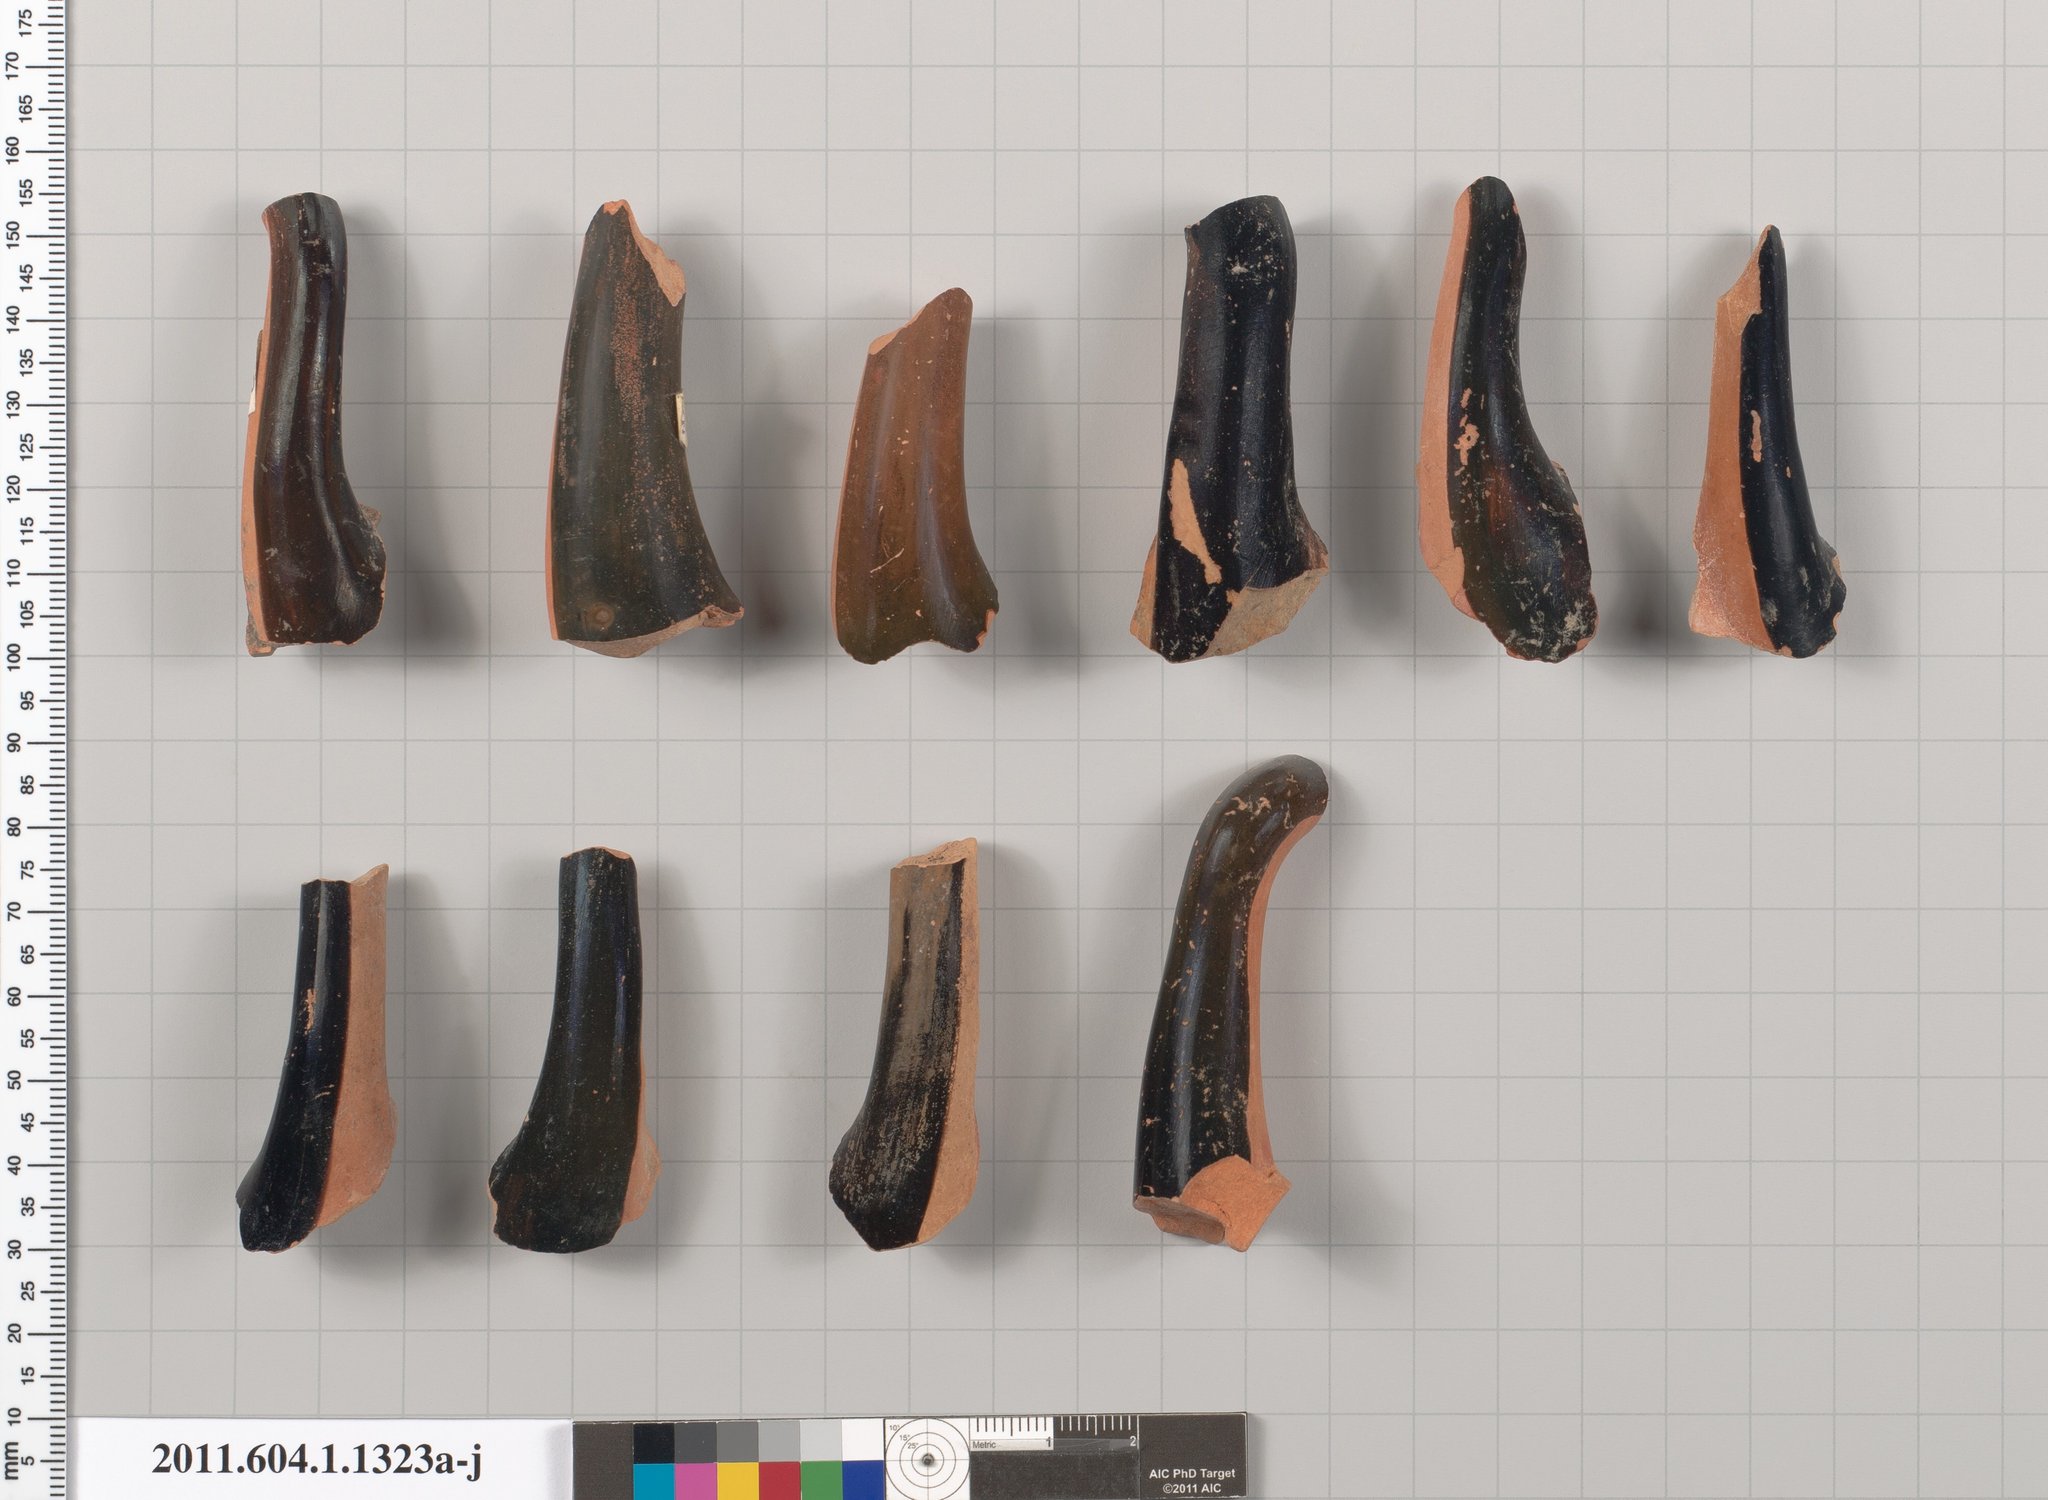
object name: kylix fragment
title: Terracotta fragments of kylikes (drinking cups)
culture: greek, attic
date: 500-401 BCE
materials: terracotta